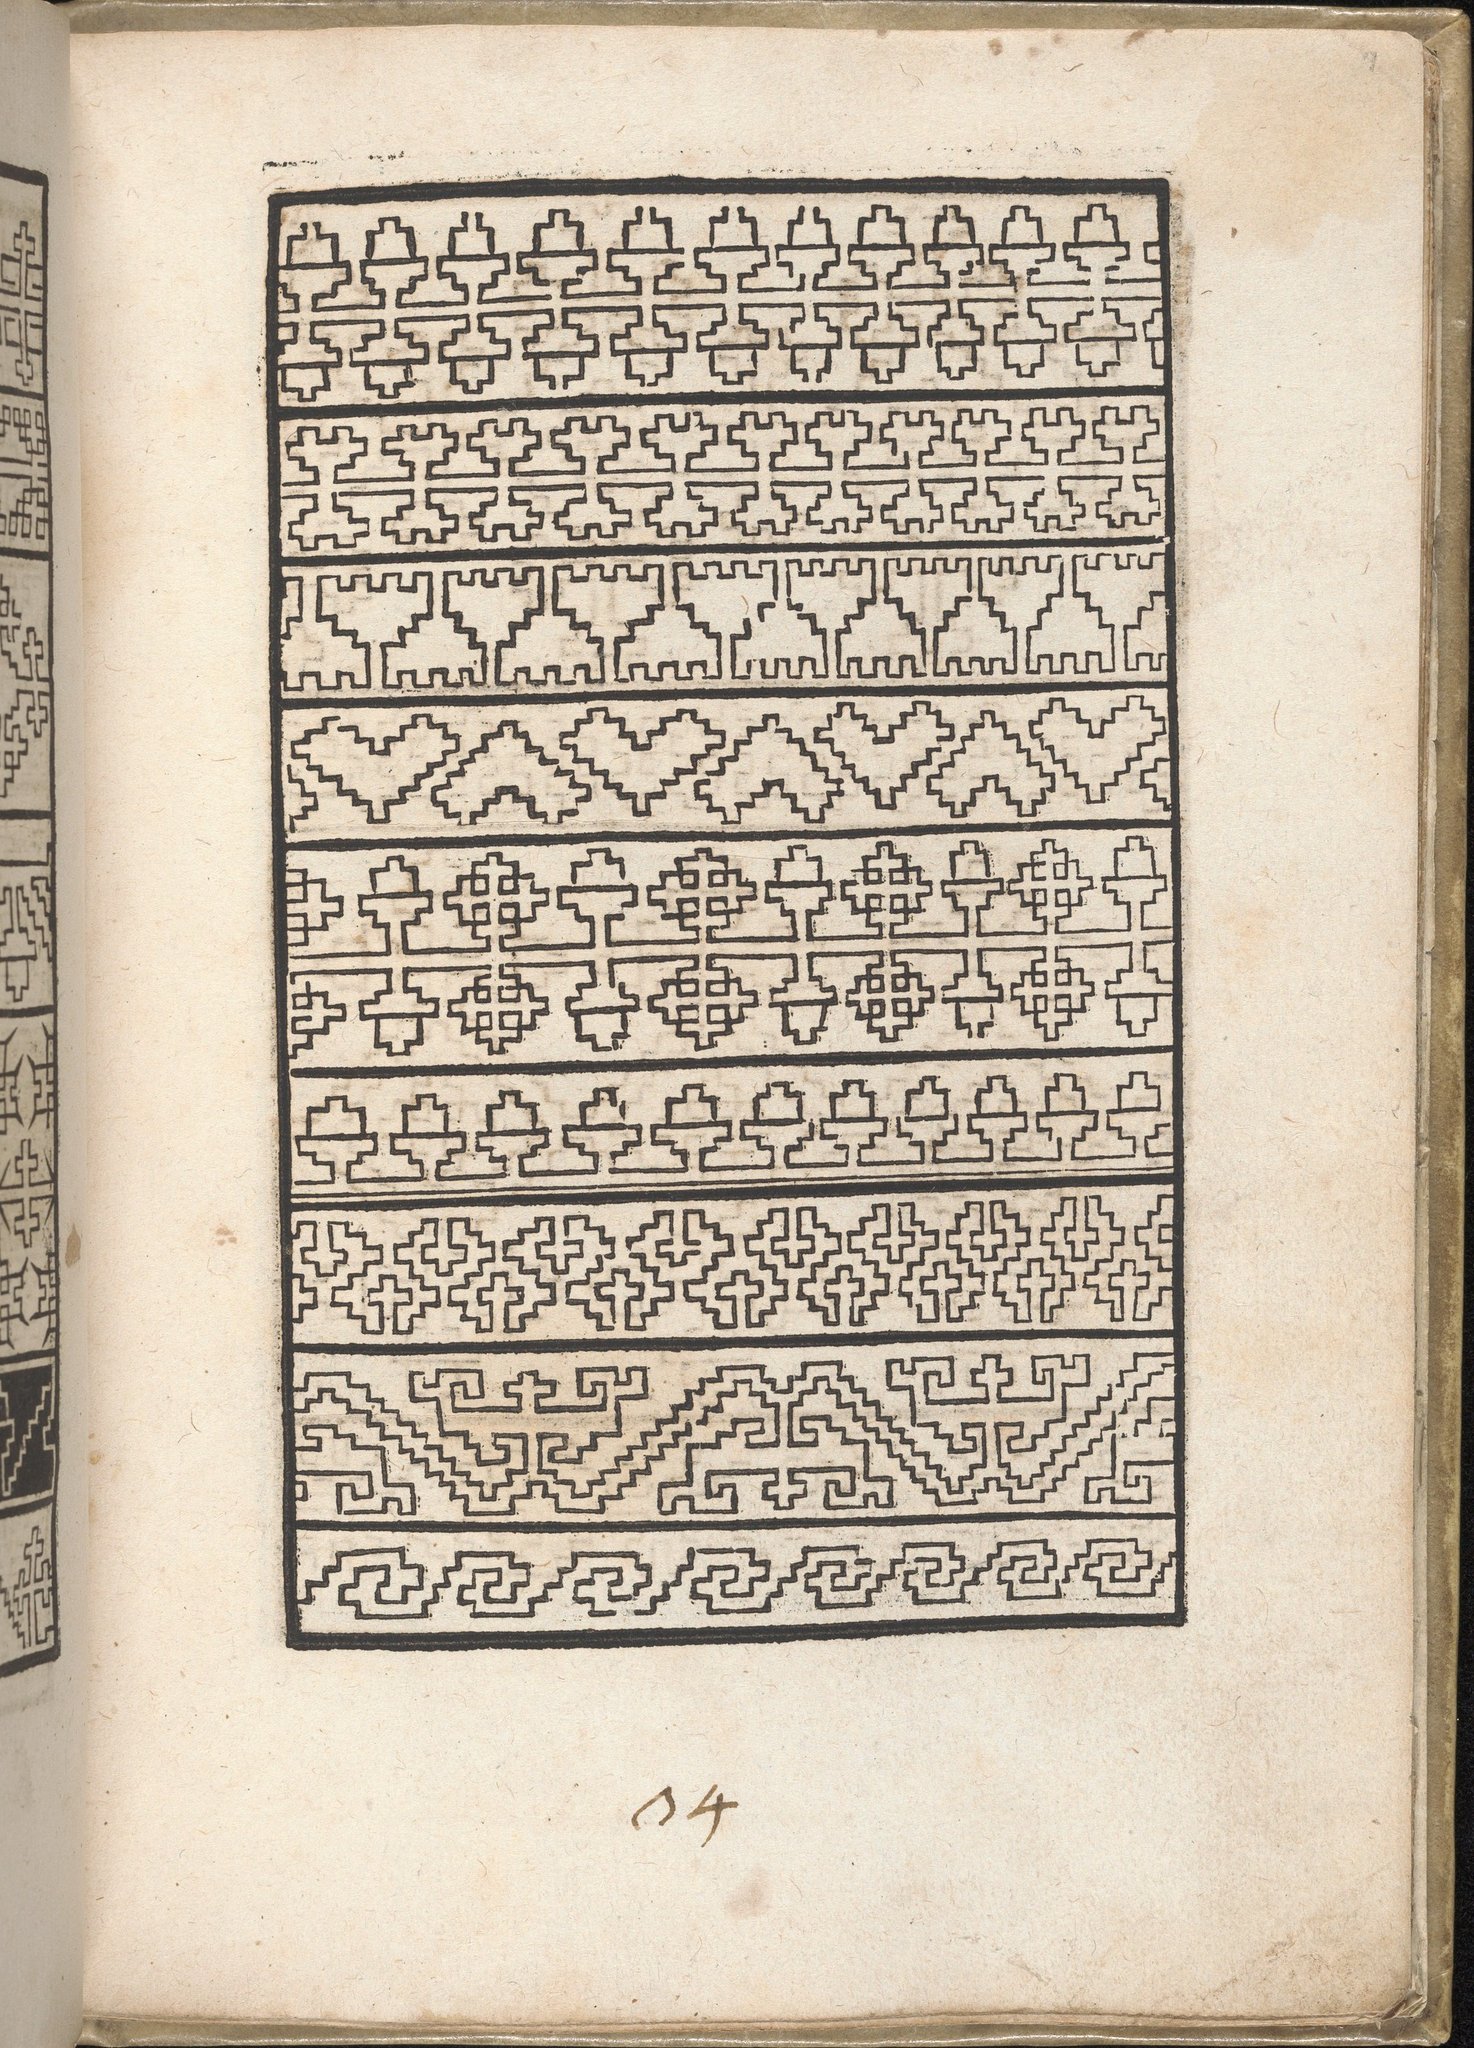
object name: book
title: Page 8r, from "Eyn New Kunstlichboich"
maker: peter quentel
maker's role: publisher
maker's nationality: german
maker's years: 1500-1550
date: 1529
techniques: woodcut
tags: ornament